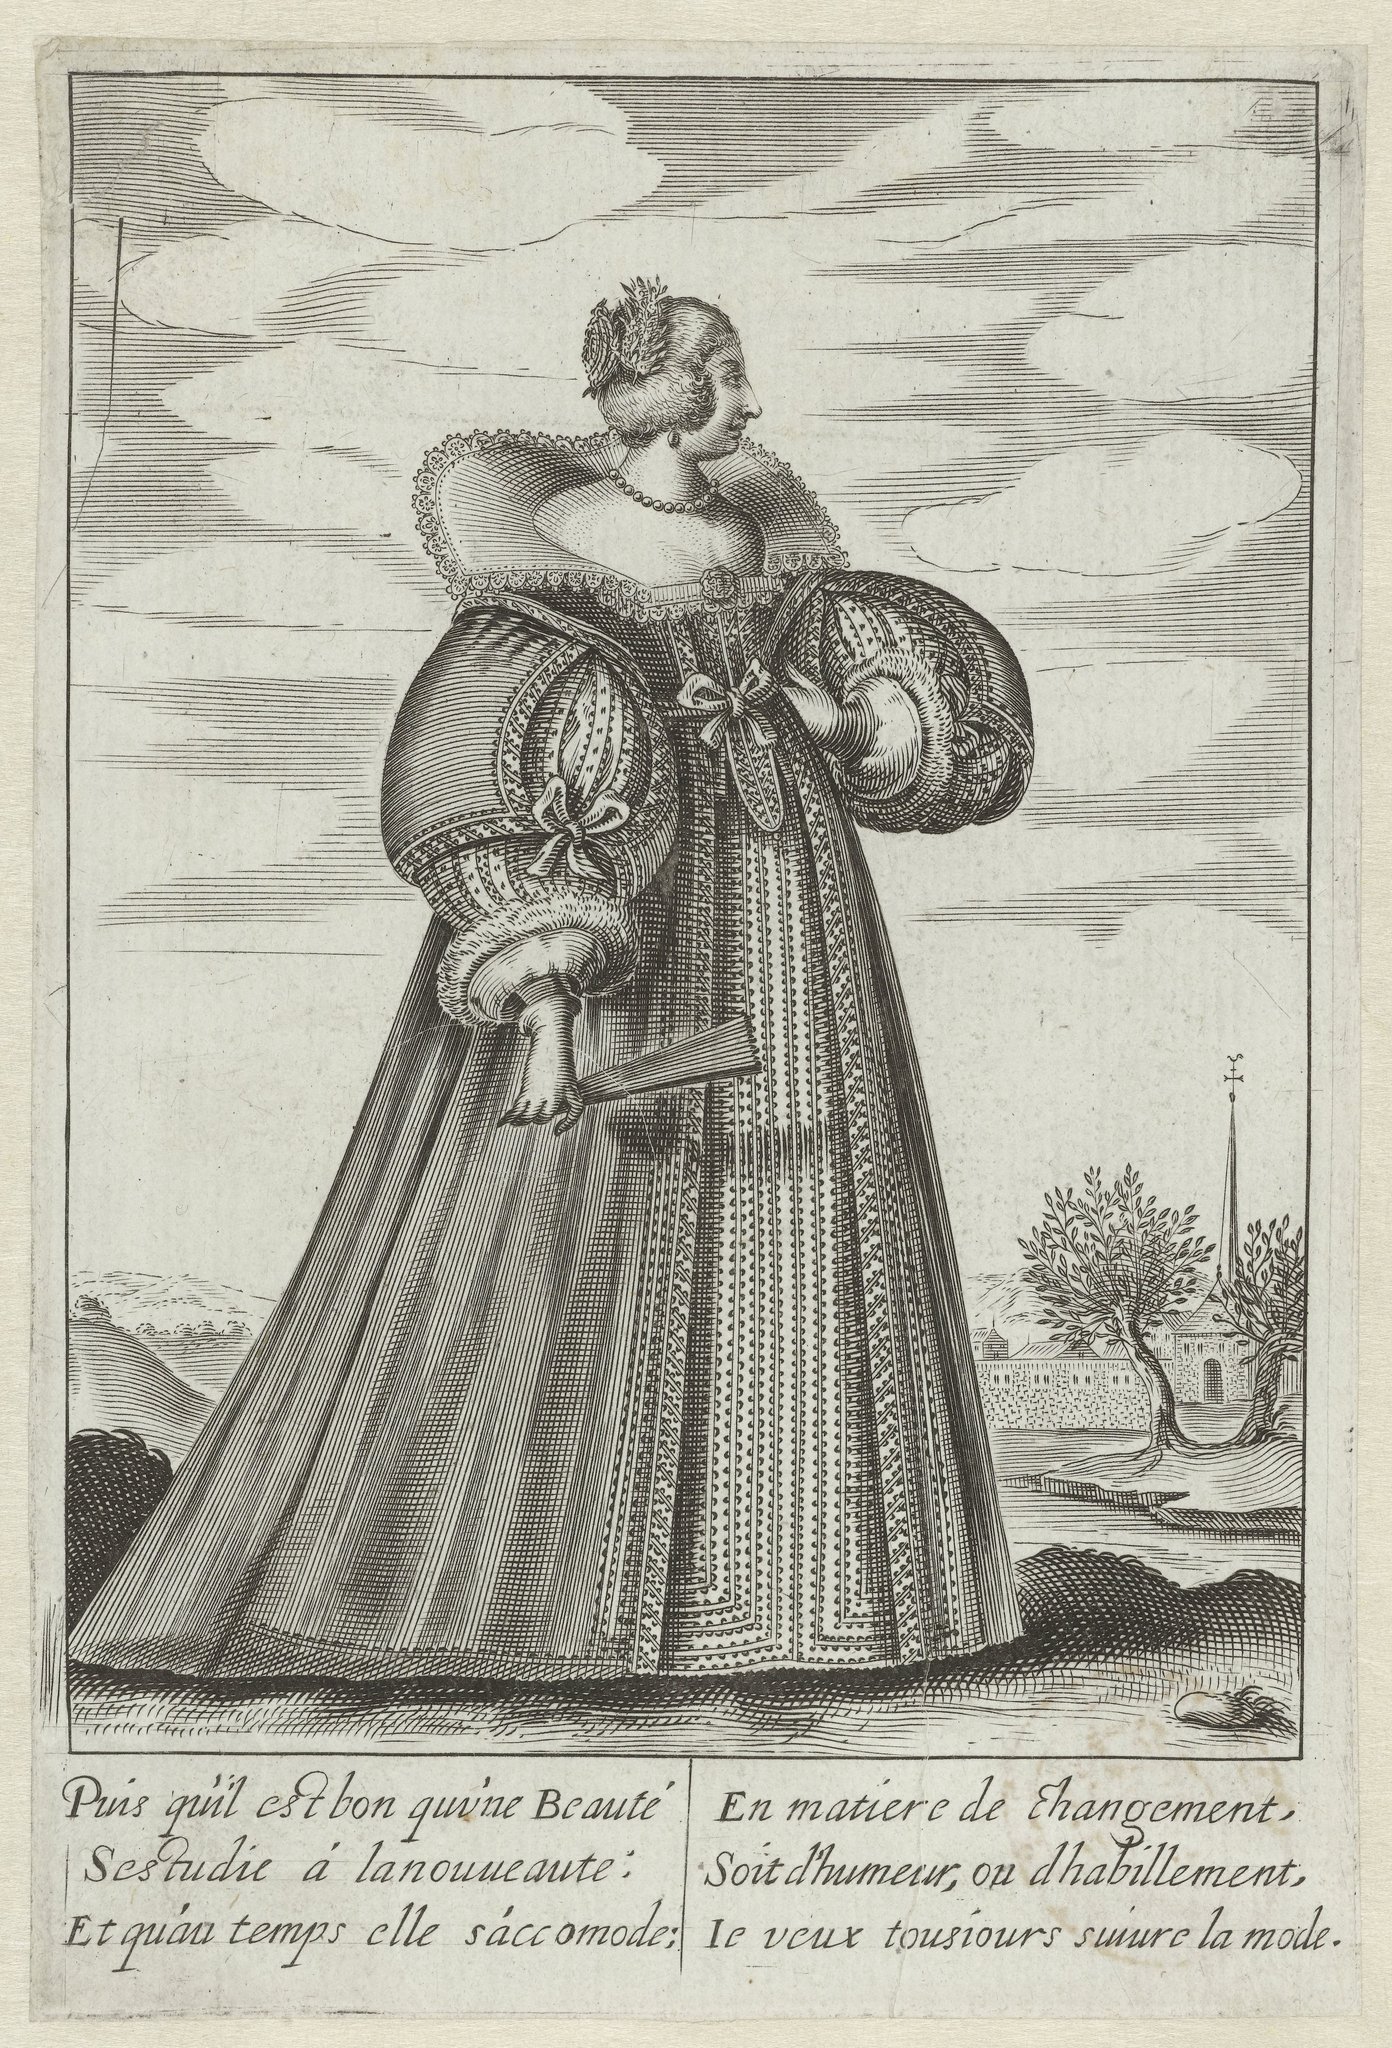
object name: costume print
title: Diversitez d'Habillemens a la mode (...)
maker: isaac briot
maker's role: print maker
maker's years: 1585-1670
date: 1630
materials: paper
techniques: engraving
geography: france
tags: bow (ornamental part of clothing) (+ women's clothes), ear-rings (+ women's clothes), dress, gown (vlieger) (+ women's clothes), styles of hairdress - aa - ~ women, 'décolleté', neck-gear: collar (+ women's clothes), fashion plates, skirt (+ women's clothes), fan (+ women's clothes), dignitary at court - bb - female dignitary: lady-in-waiting, sleeves (+ women's clothes), necklace (+ women's clothes)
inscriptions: collector's mark: Lugt 240, caption: ‘Puisqu'il est bon qu'une beauté / Sestudie a la nouveauté / Et qu'an temps elle s'accomode; / En matiere de changement / Soit d'humeur, ou dhabillement, Ie veux tousiours suivre la mode.’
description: Franse hofdame gekleed volgens de mode ca. 1630, van opzij gezien, staand voor een landschap. Zij is gekleed in een vliegerkostuum met ballonvormige open mouwen met ronde, breed uitstaande manchetten. Ze heeft een hoog aangegeven taillelijn met strik van voren en een onbedekt décolleté. In de hals heeft zij een breed uitstaande kraag (van schouder tot schouder). Ze draagt een kort kapsel met versiering en in haar hand een dichtgevouwen waaier. Met onderaan een onderschrift.